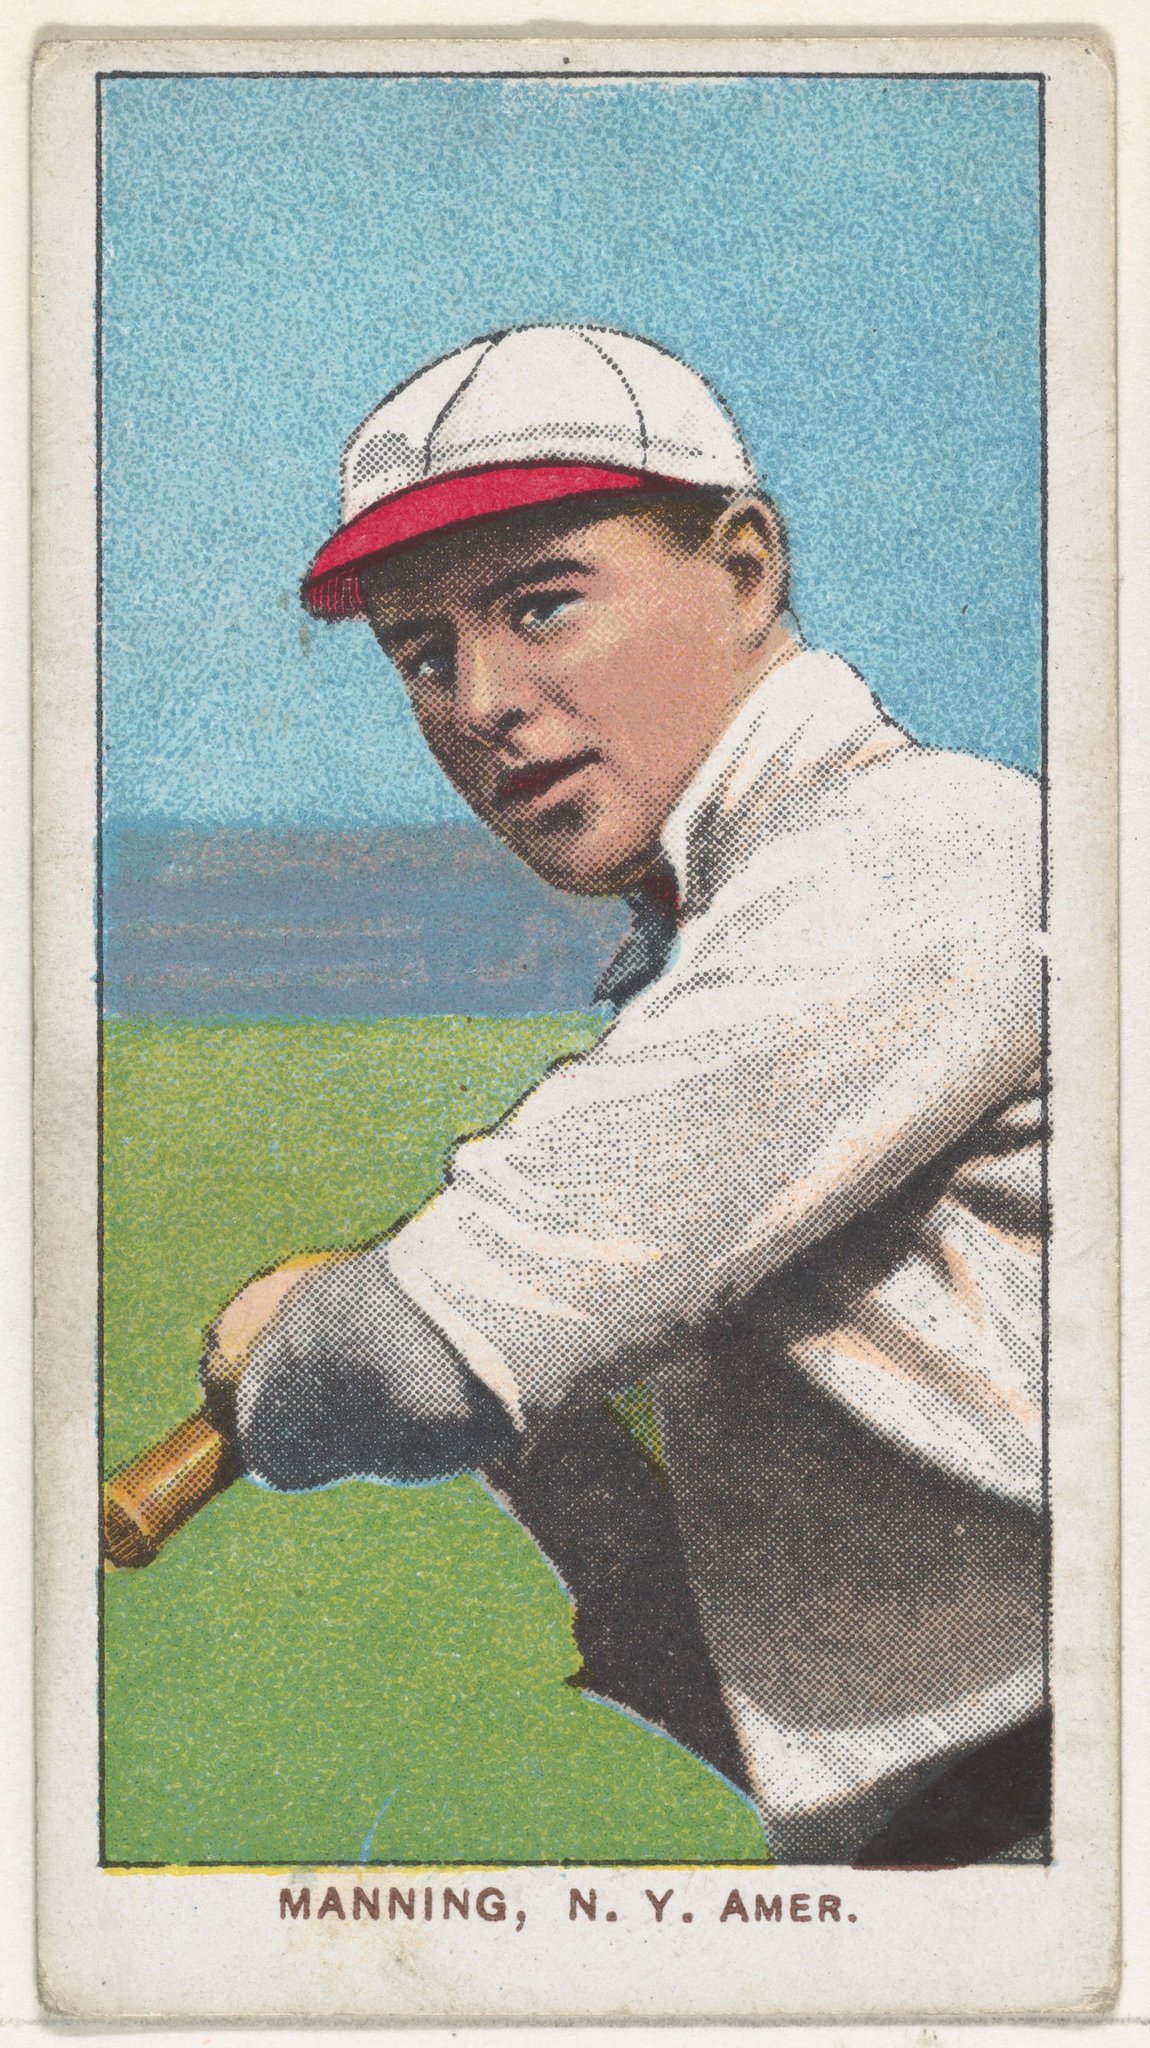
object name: baseball card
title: Manning, New York, American League, from the White Border series (T206) for the American Tobacco Company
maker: american tobacco company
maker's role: publisher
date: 1909-1911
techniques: color lithograph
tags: men,portraits,baseball,athletes